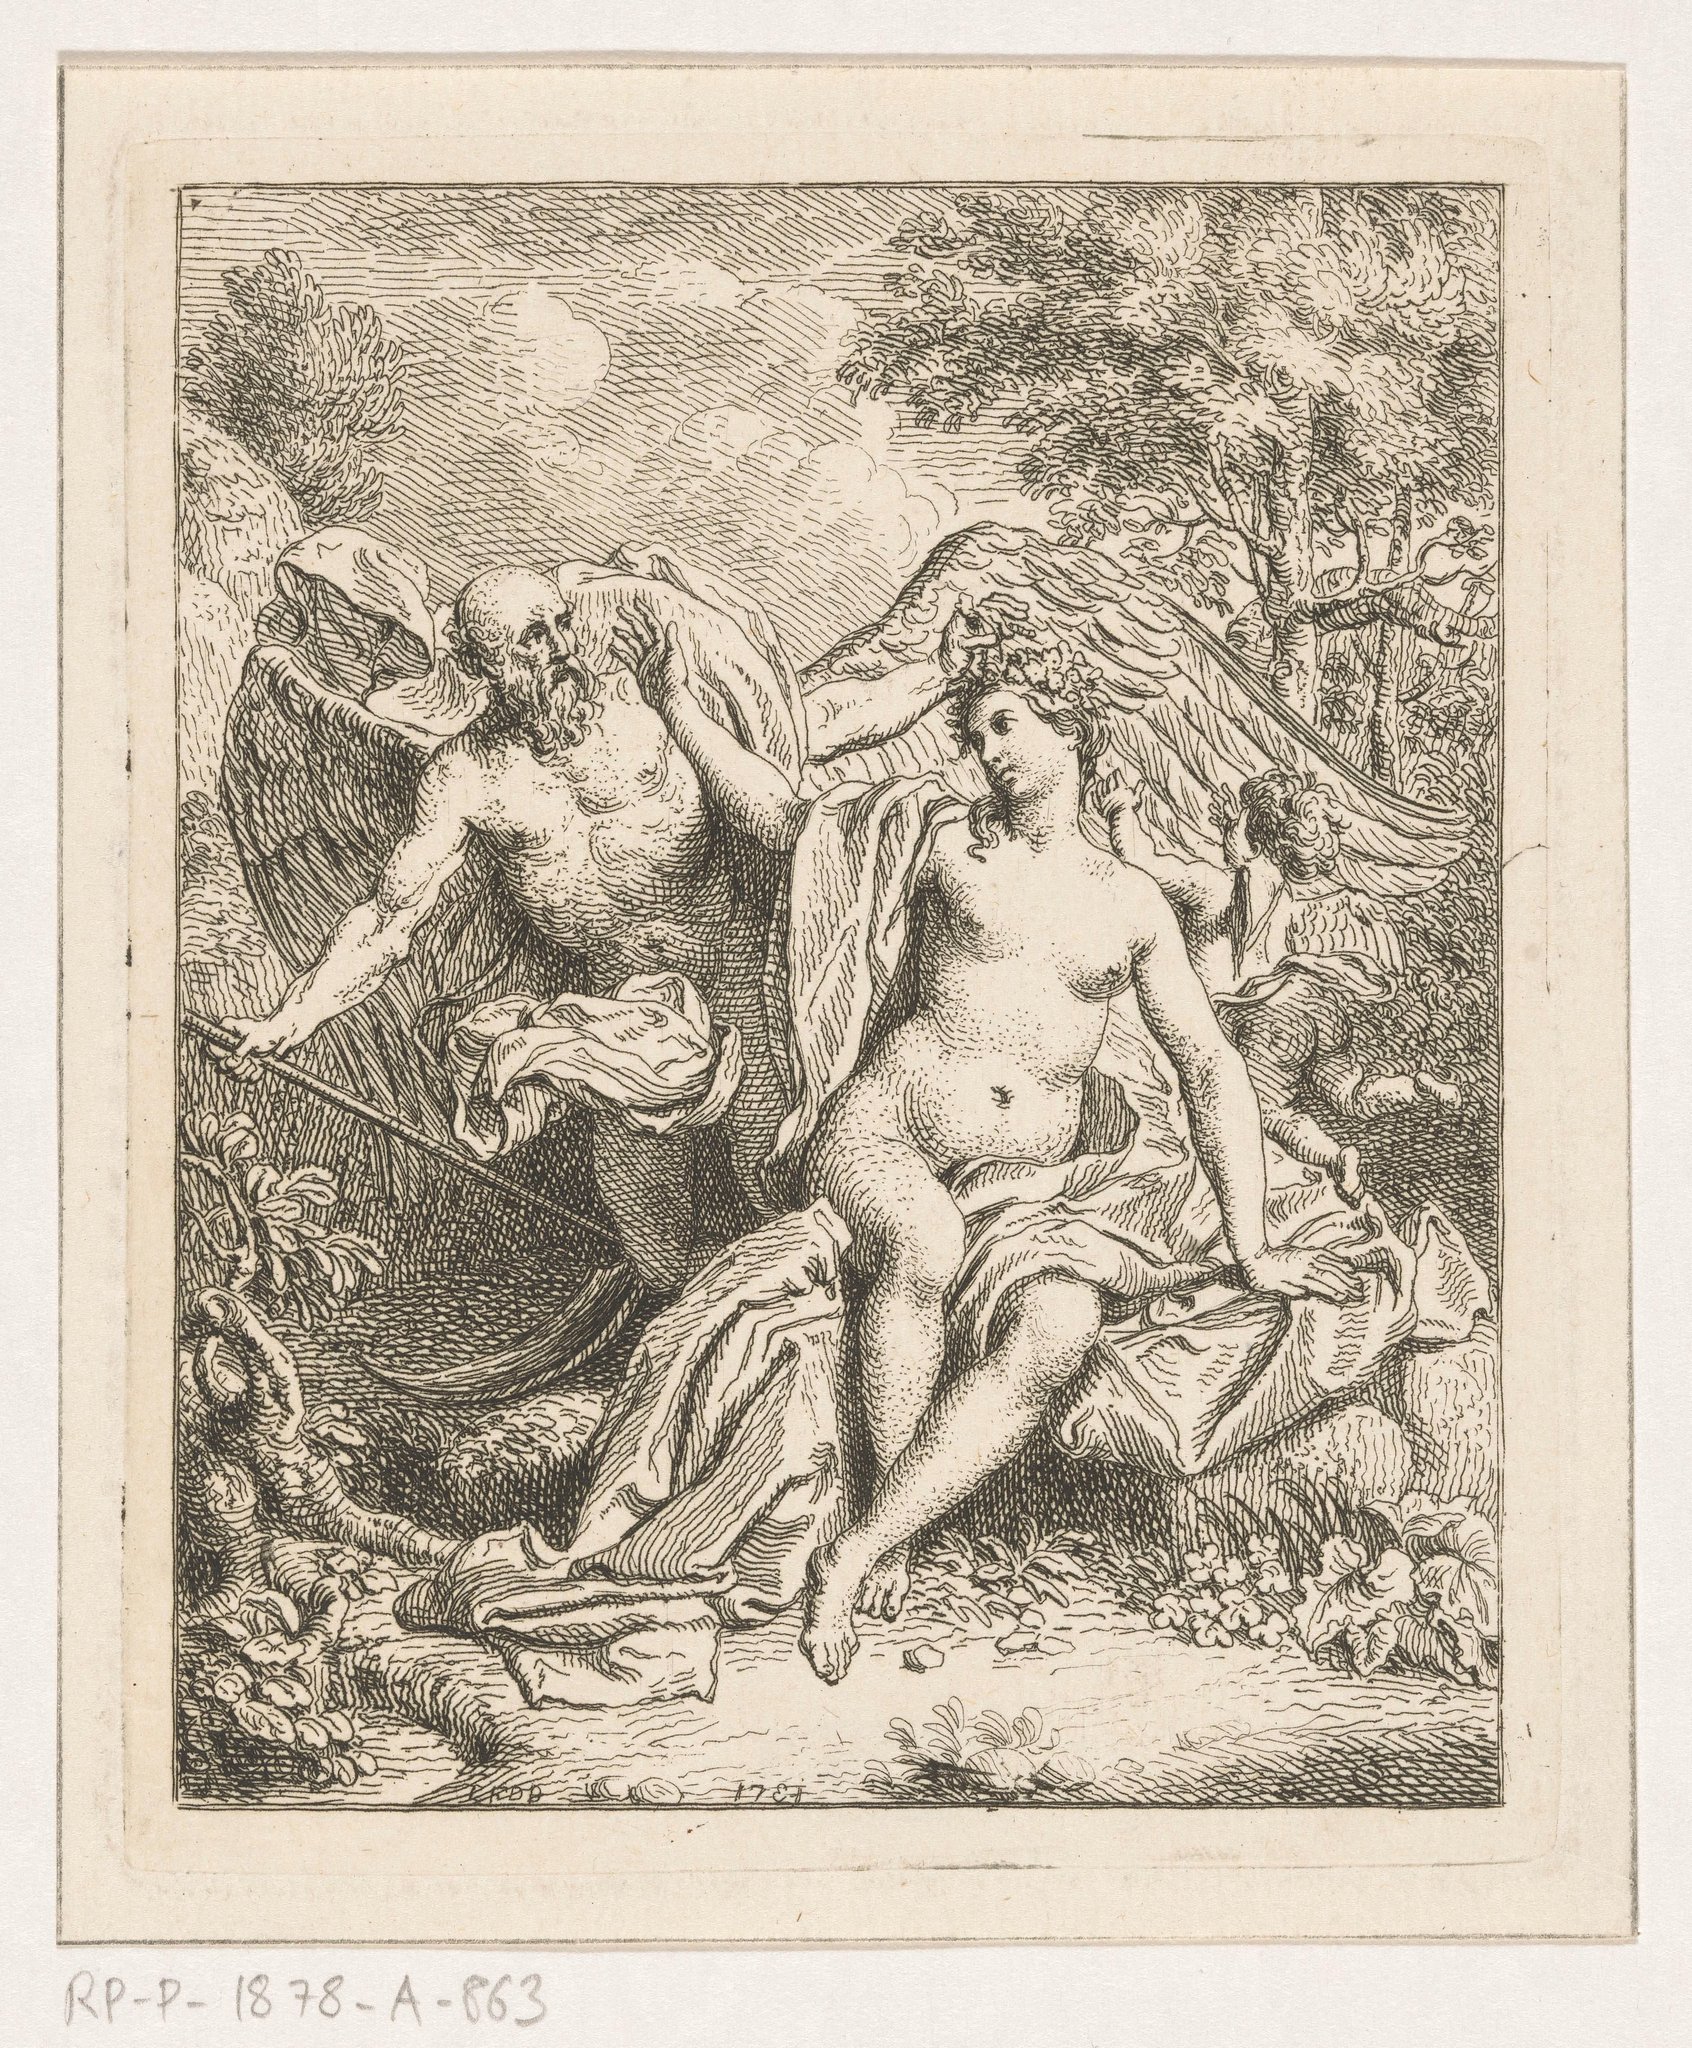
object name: print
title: Vader Tijd onthuld de Waarheid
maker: louis fabritius dubourg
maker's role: draughtsman, print maker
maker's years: 1693-1775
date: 1737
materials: paper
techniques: etching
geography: amsterdam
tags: time revealing truth; time carrying truth aloft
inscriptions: collector's mark: Lugt 2228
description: Vader Tijd en een putto onthullen de personificatie van de Waarheid. De Waarheid zit op een steen in de buitenlucht.